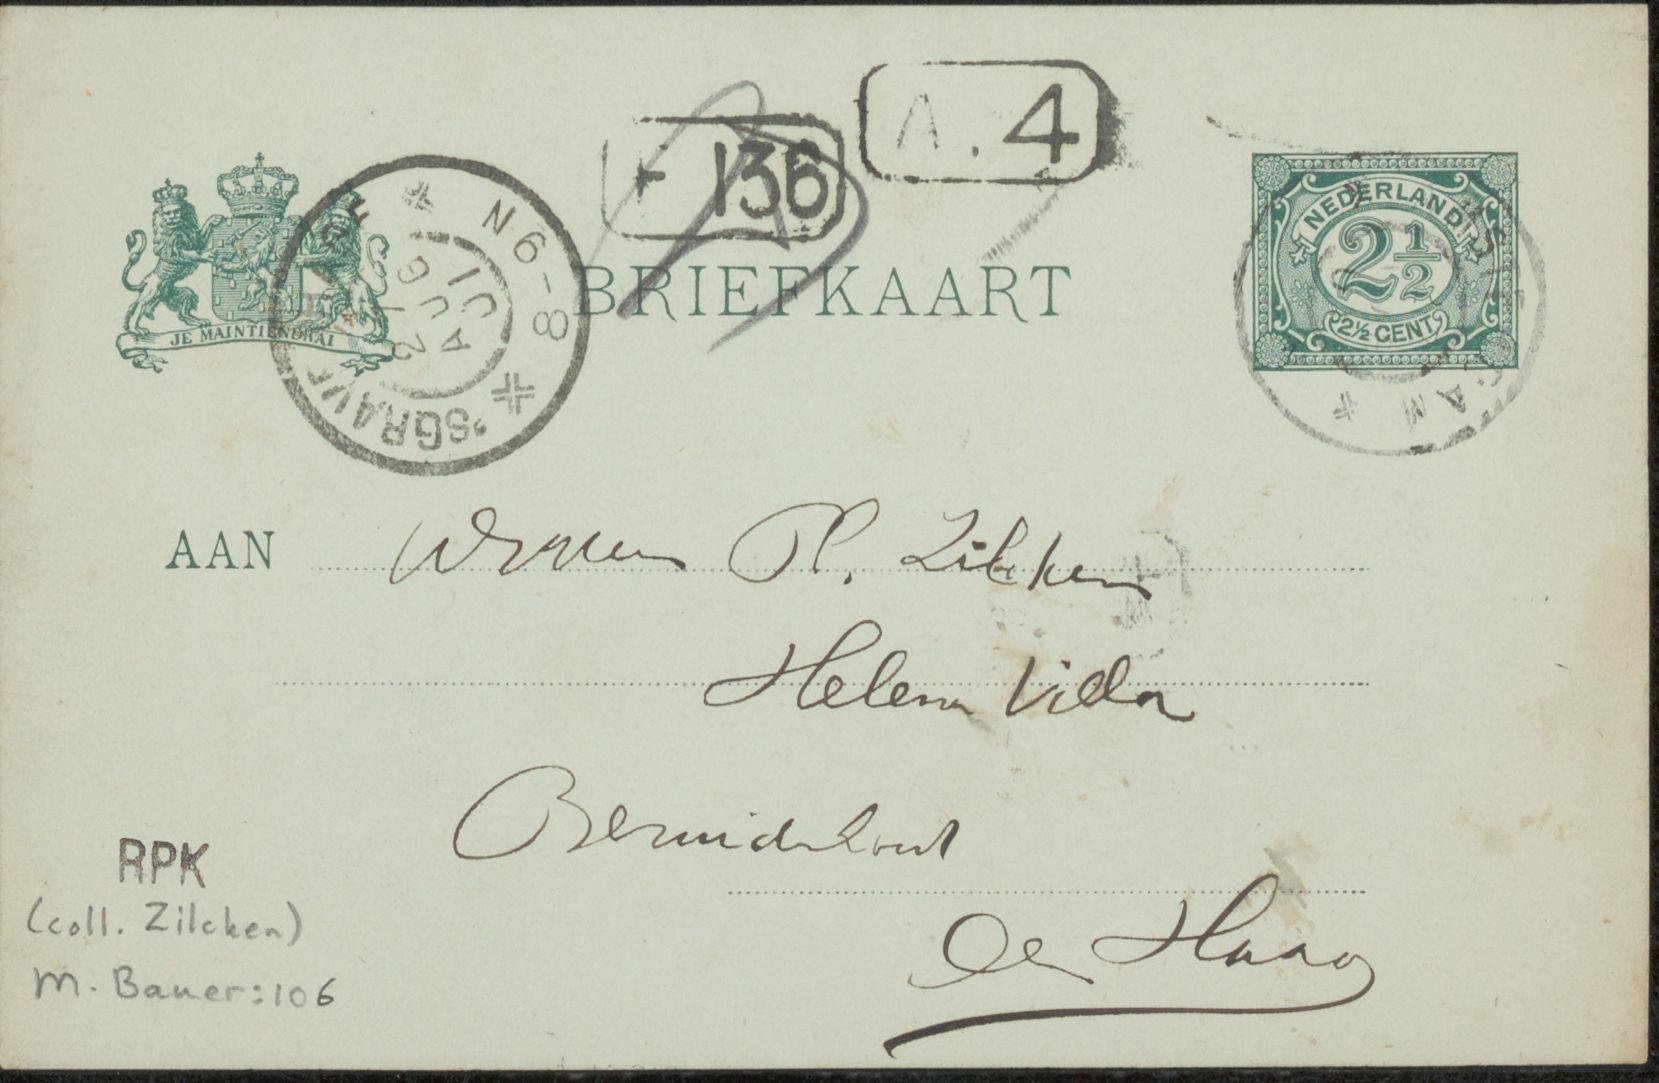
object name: postcard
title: Briefkaart aan Philip Zilcken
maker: marius bauer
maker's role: draughtsman, print maker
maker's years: 1867-1932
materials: cardboard, ink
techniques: pen, writing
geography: the hague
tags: johanna bauer-stumpff, the hague, painter, draughtsman, philip zilcken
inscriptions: collector's mark: ‘RPK’